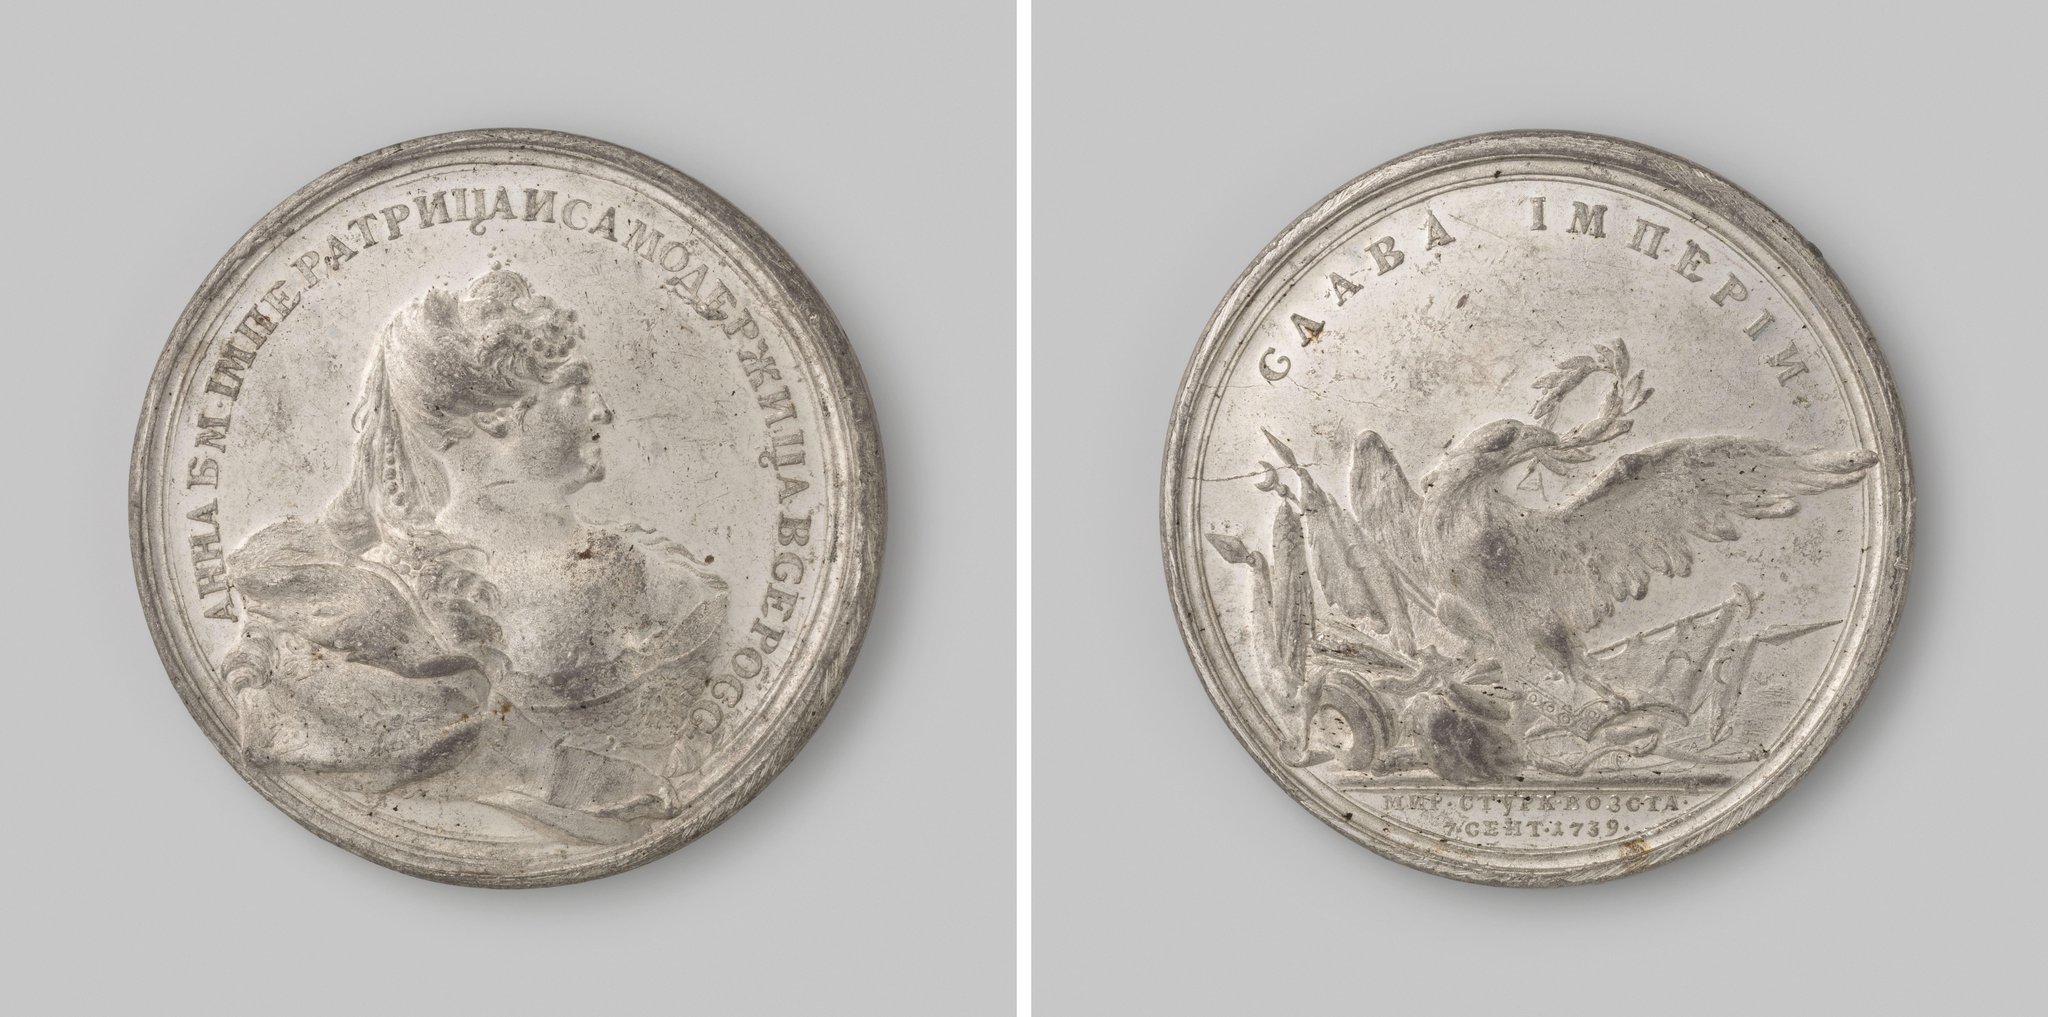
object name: history medal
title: Vrede van Rusland met Turkije onder de regering van Tsarina Anna 1739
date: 1739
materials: tin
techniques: striking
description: Tinnen penning, op de voorzijde het borstbeeld van Tsarina Anna naar rechts met omschrift, op de keerzijde een adelaar met lauwerkrans in de snavel op een stapel militaire attributen, met omschrift en afsnedetekst.